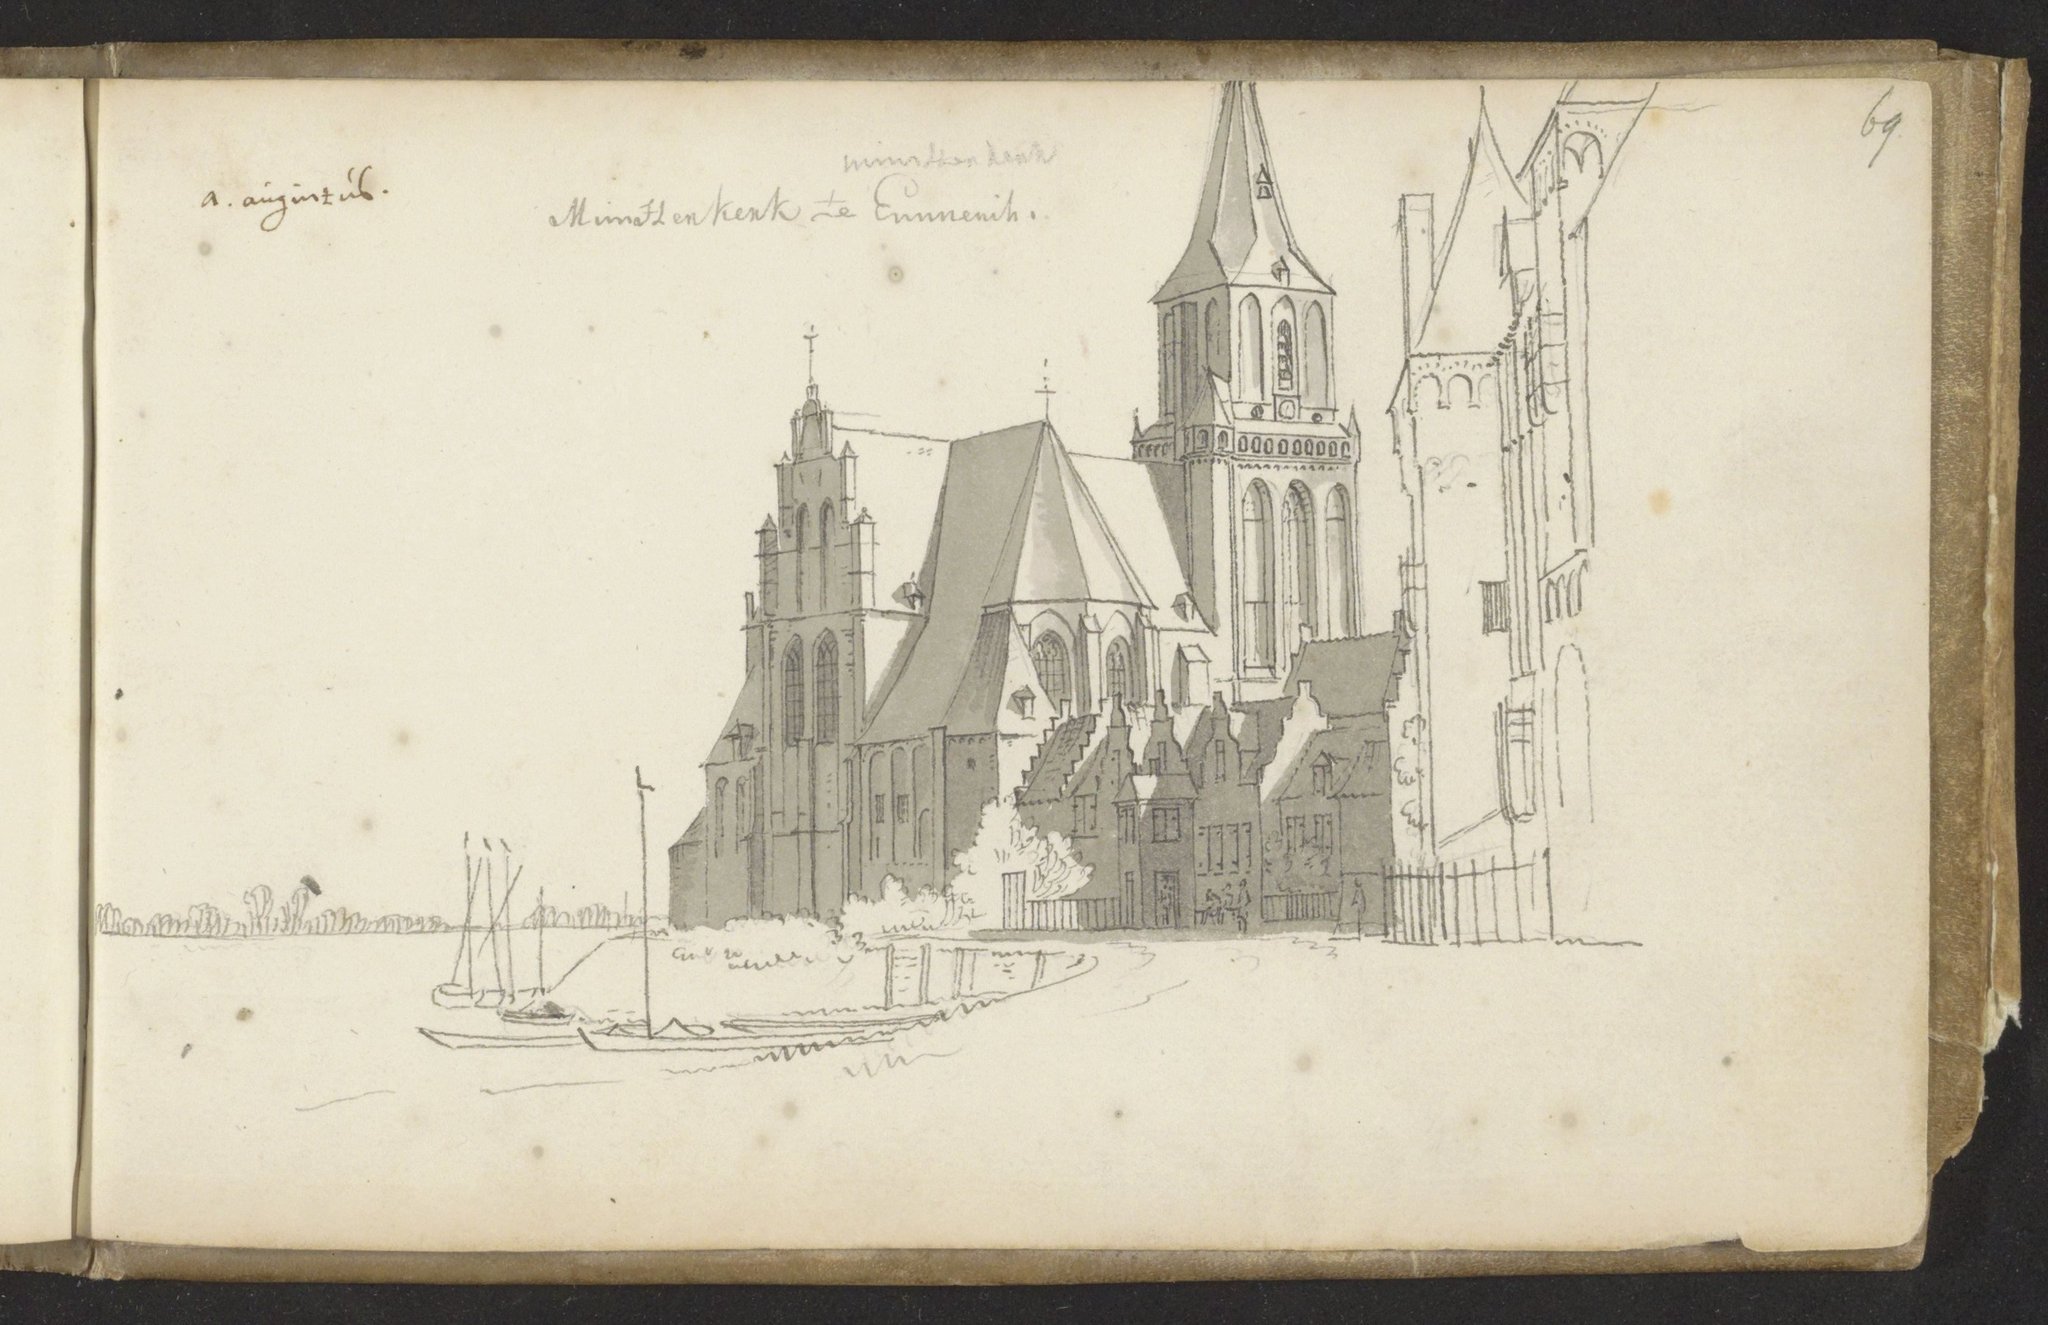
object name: sketchbook leaf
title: Stadsgezicht met kerk te Emmerik aan de Rijn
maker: abraham de haen (ii)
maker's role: draughtsman, print maker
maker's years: 1707-1748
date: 1731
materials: ink, paper, pencil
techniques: brush, pen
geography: emmerik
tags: church (exterior), canals, waters (in city)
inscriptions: date and inscription: ‘4 augustus/ Munsterkerk te Emmerik.’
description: Blad 69 recto uit een schetsboek met 69 bladen.